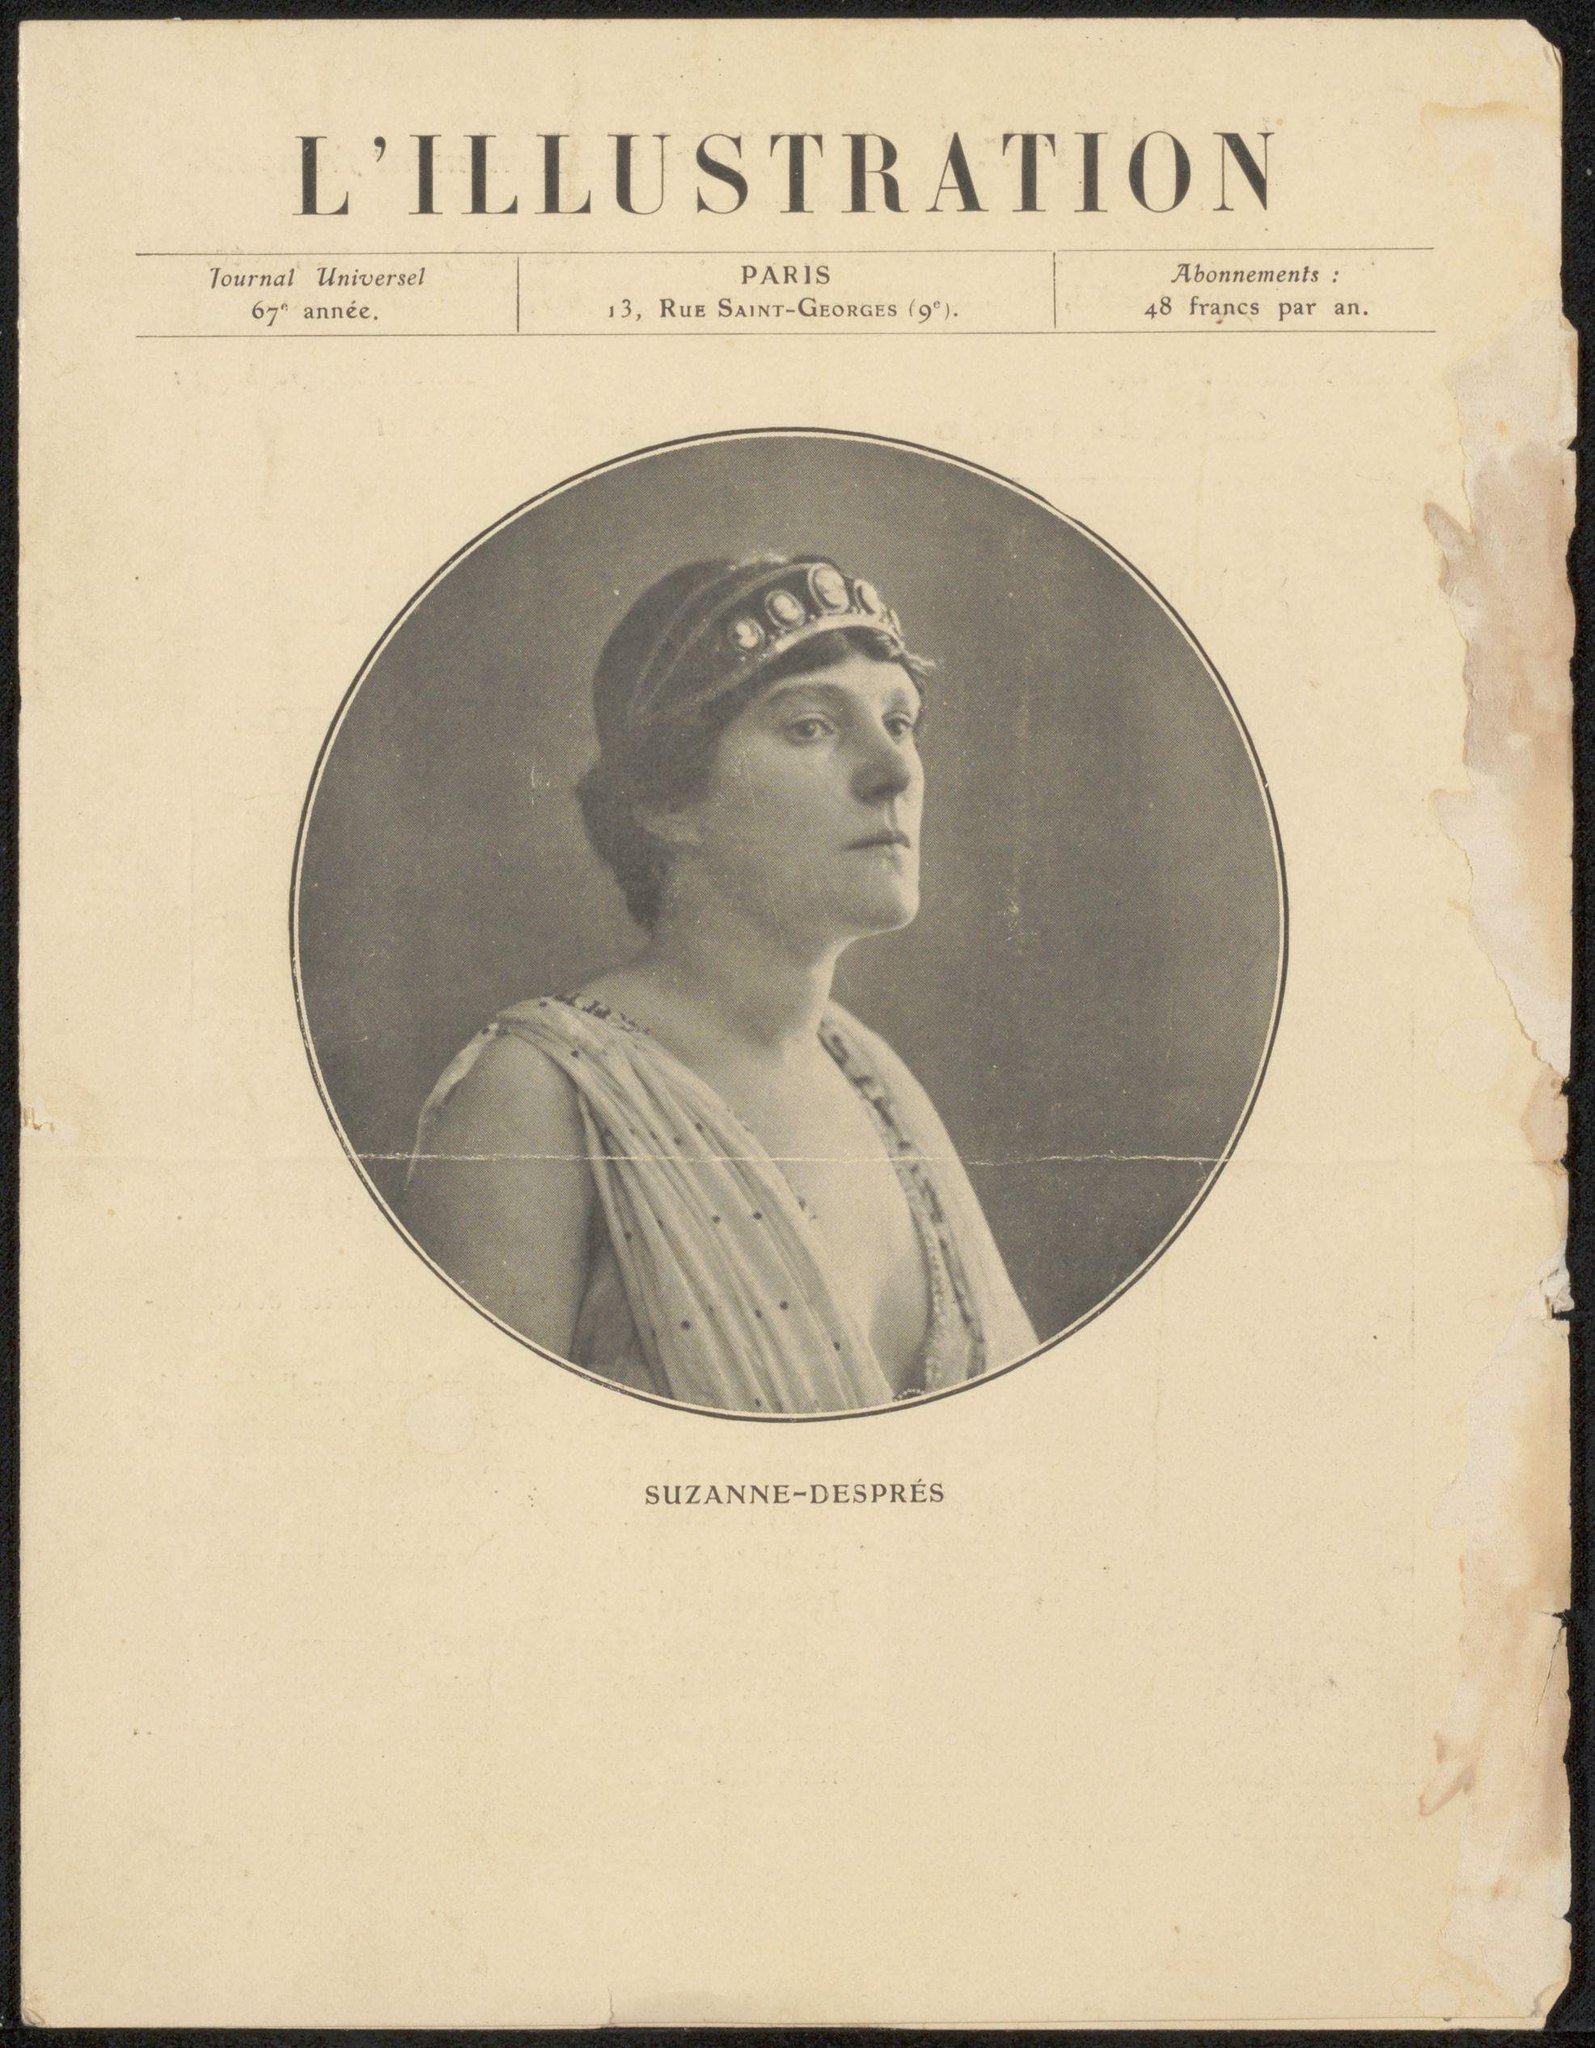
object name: magazine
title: Tijdschrift uit archief Philip Zilcken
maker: emile zola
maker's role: auteur, fotograaf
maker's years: 1840-1902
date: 1901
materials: paper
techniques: printing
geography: paris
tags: lugné-poe, paris, suzanne desprès, the hague, draughtsman, philip zilcken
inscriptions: collector's mark: ‘RPK’